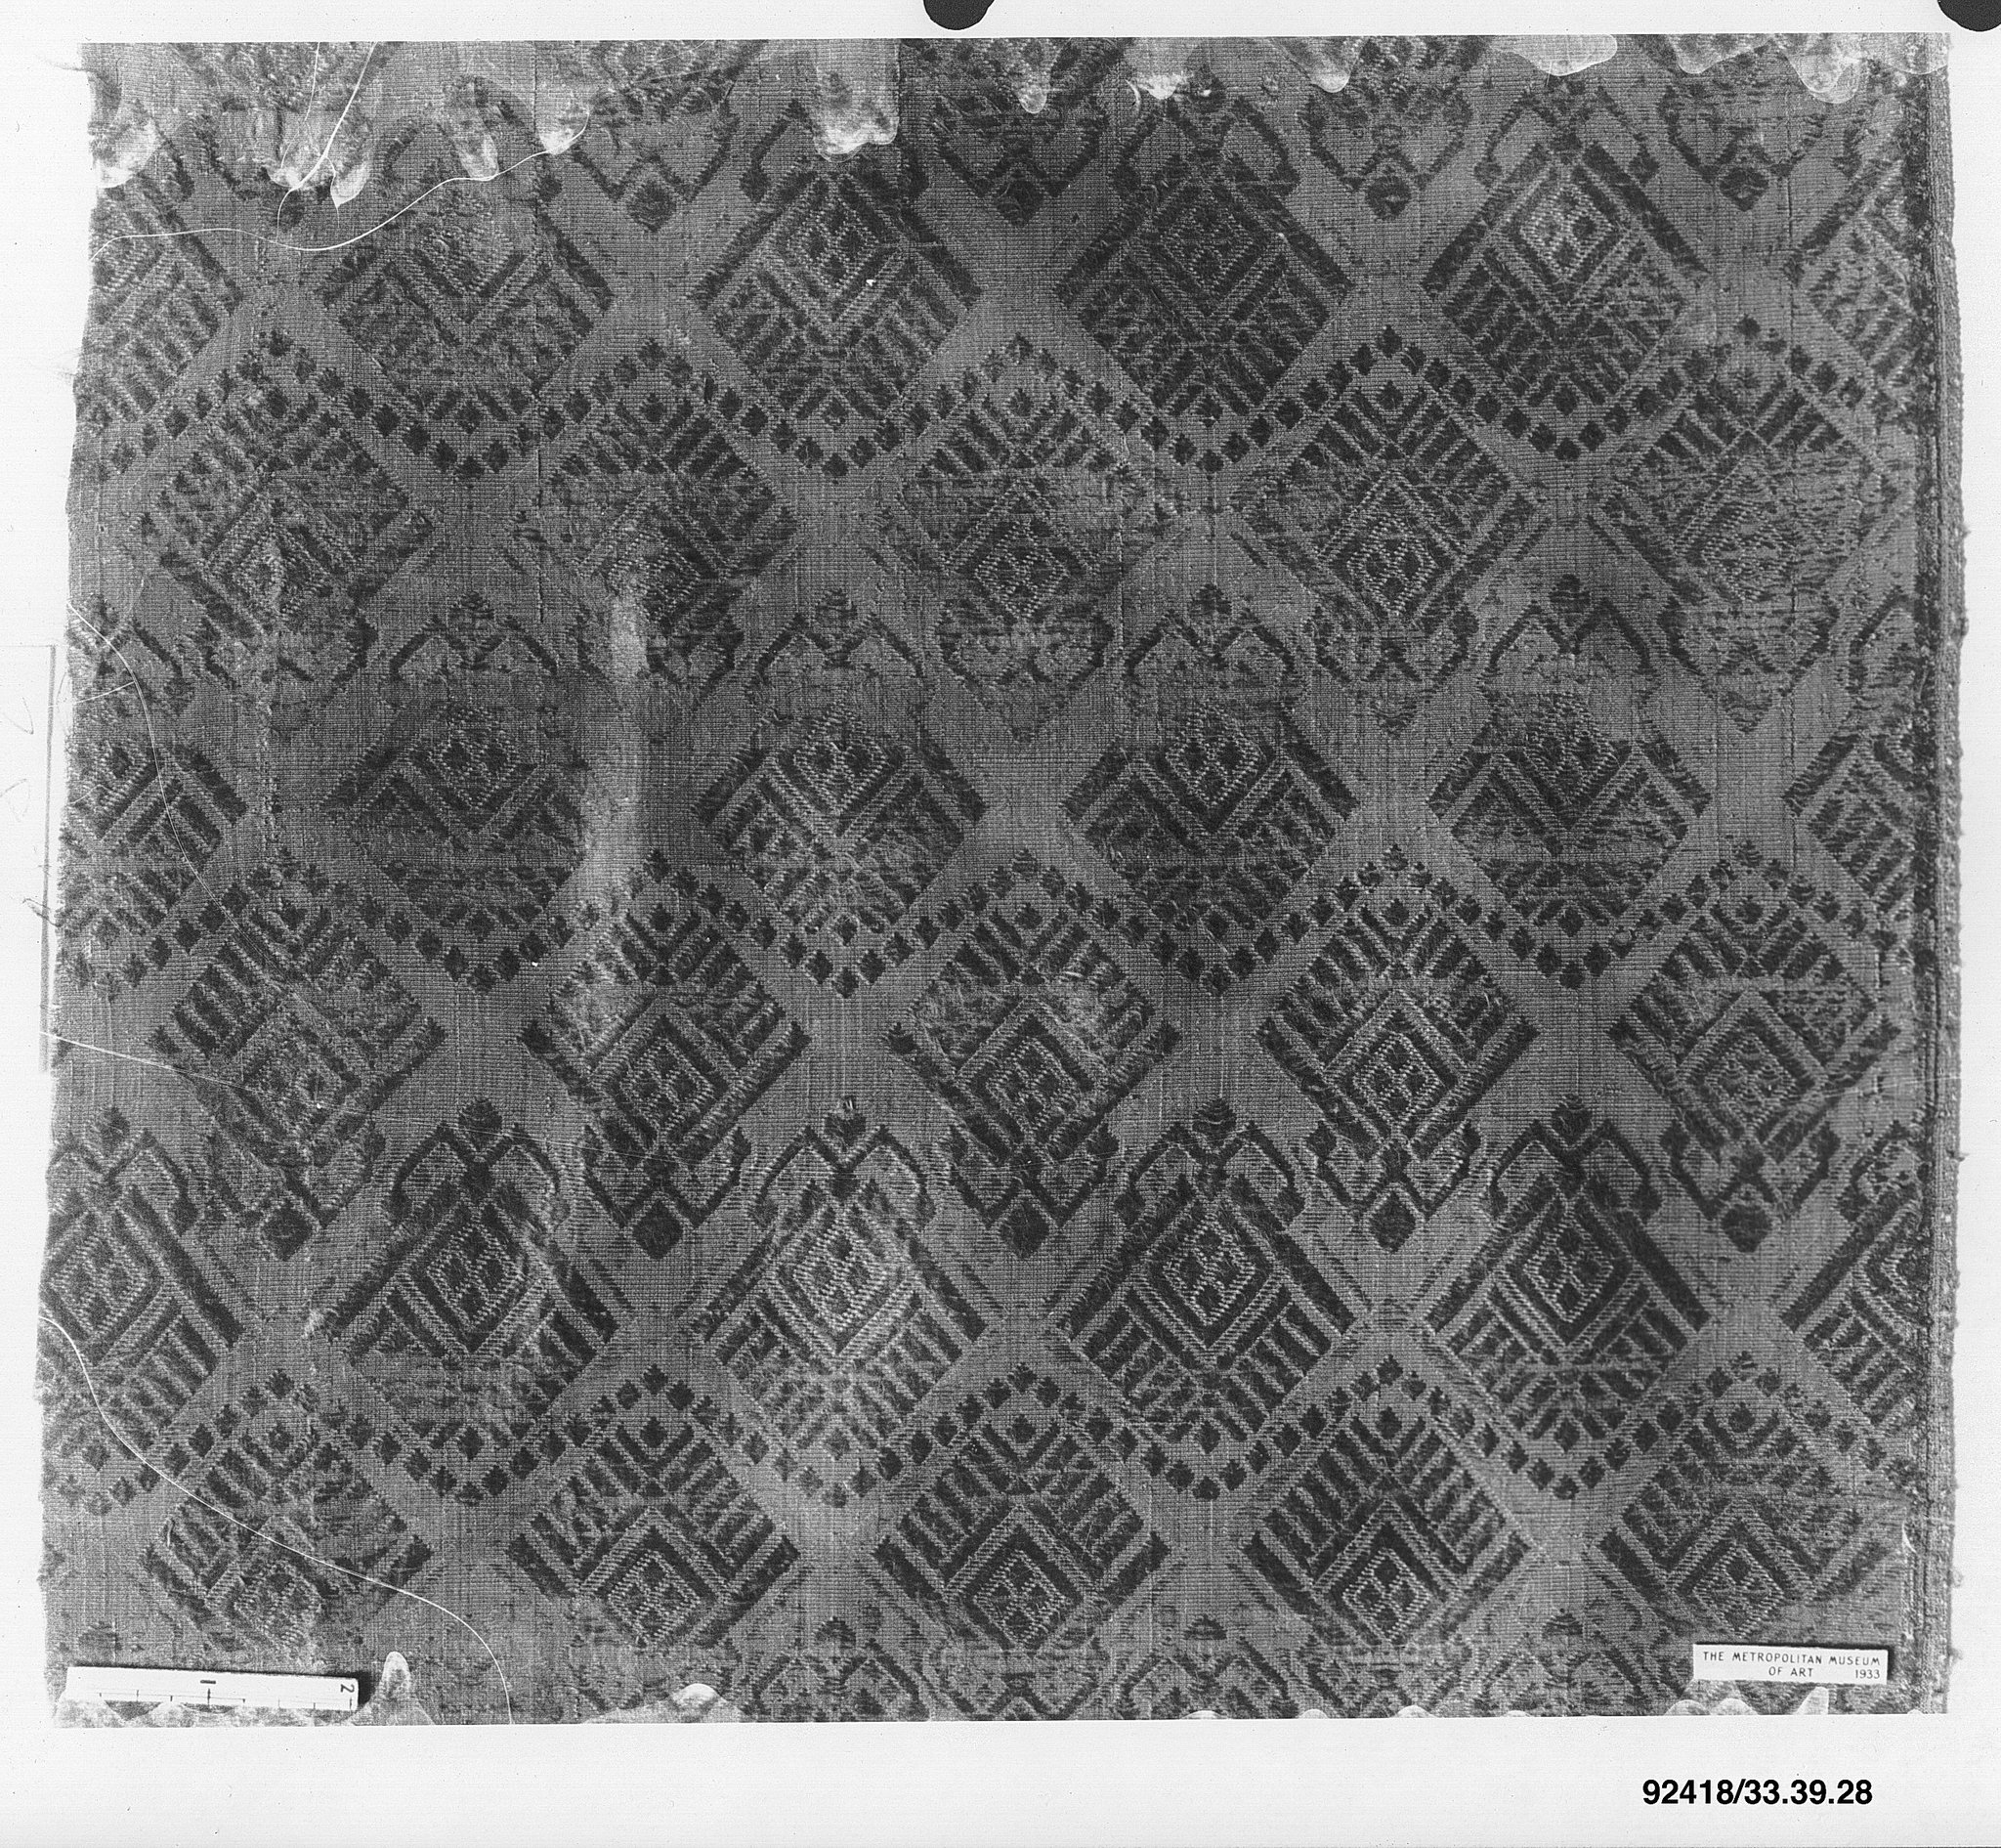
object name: piece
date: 1601-1633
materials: silk